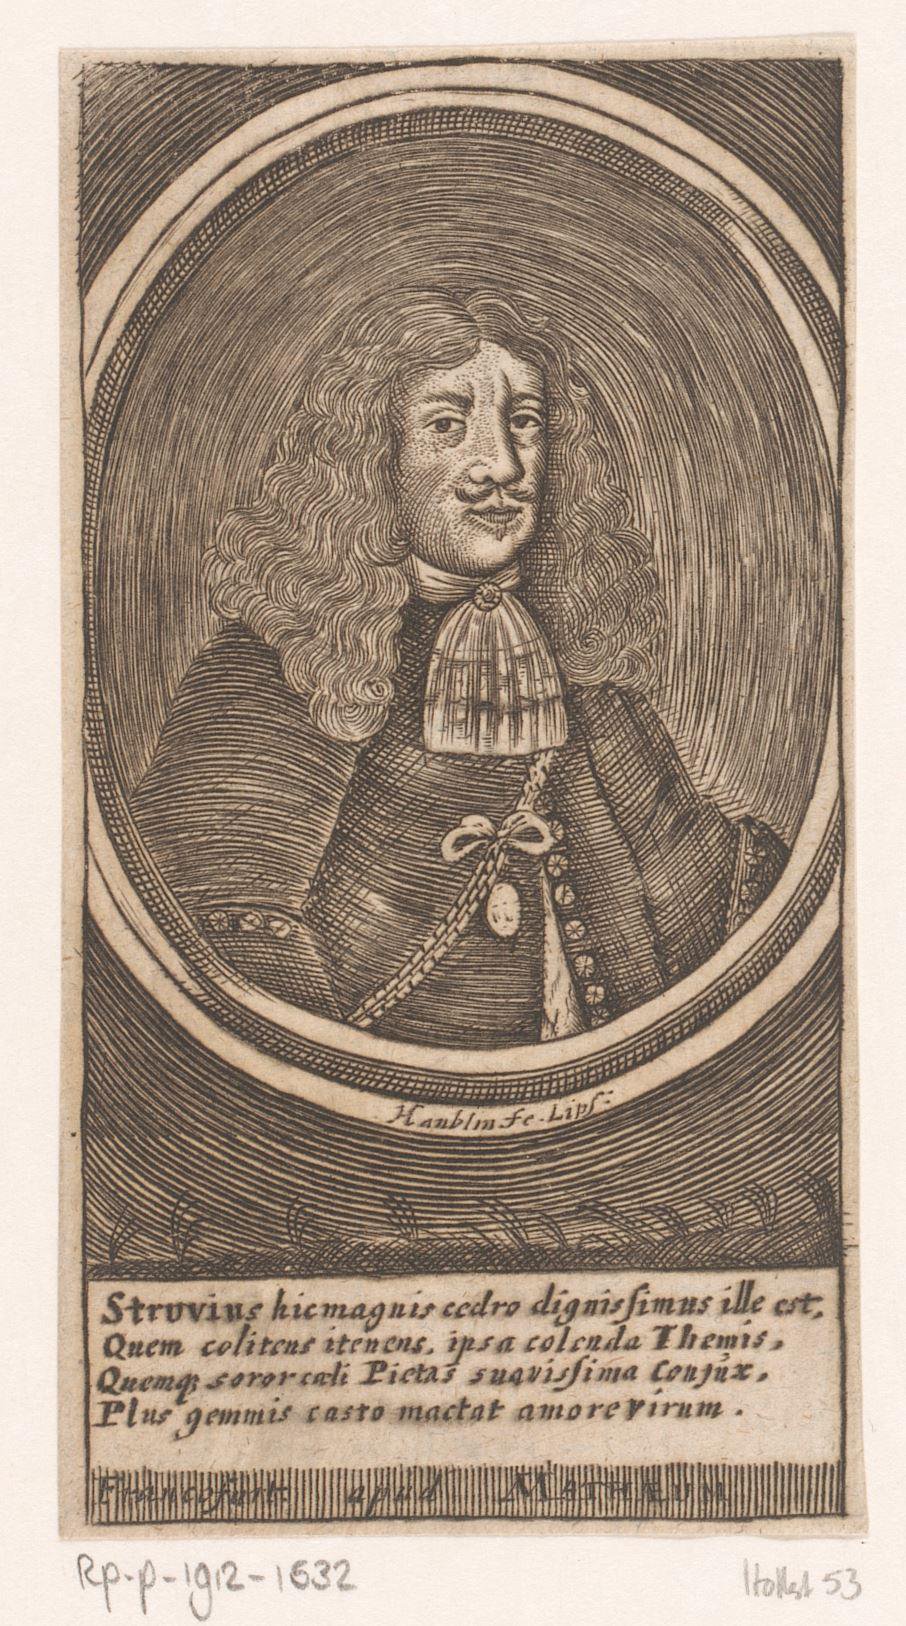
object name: print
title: Portret van Heinrich Leopold von Seherr-Thoß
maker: johann samuel ludwig halle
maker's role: print maker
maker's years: 1763-1829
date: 1796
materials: paper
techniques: engraving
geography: berlin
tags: rosette ~ ornament, historical persons, ornament ~ festoon, garland, armorial bearing, heraldry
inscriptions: collector's mark: Lugt 2228